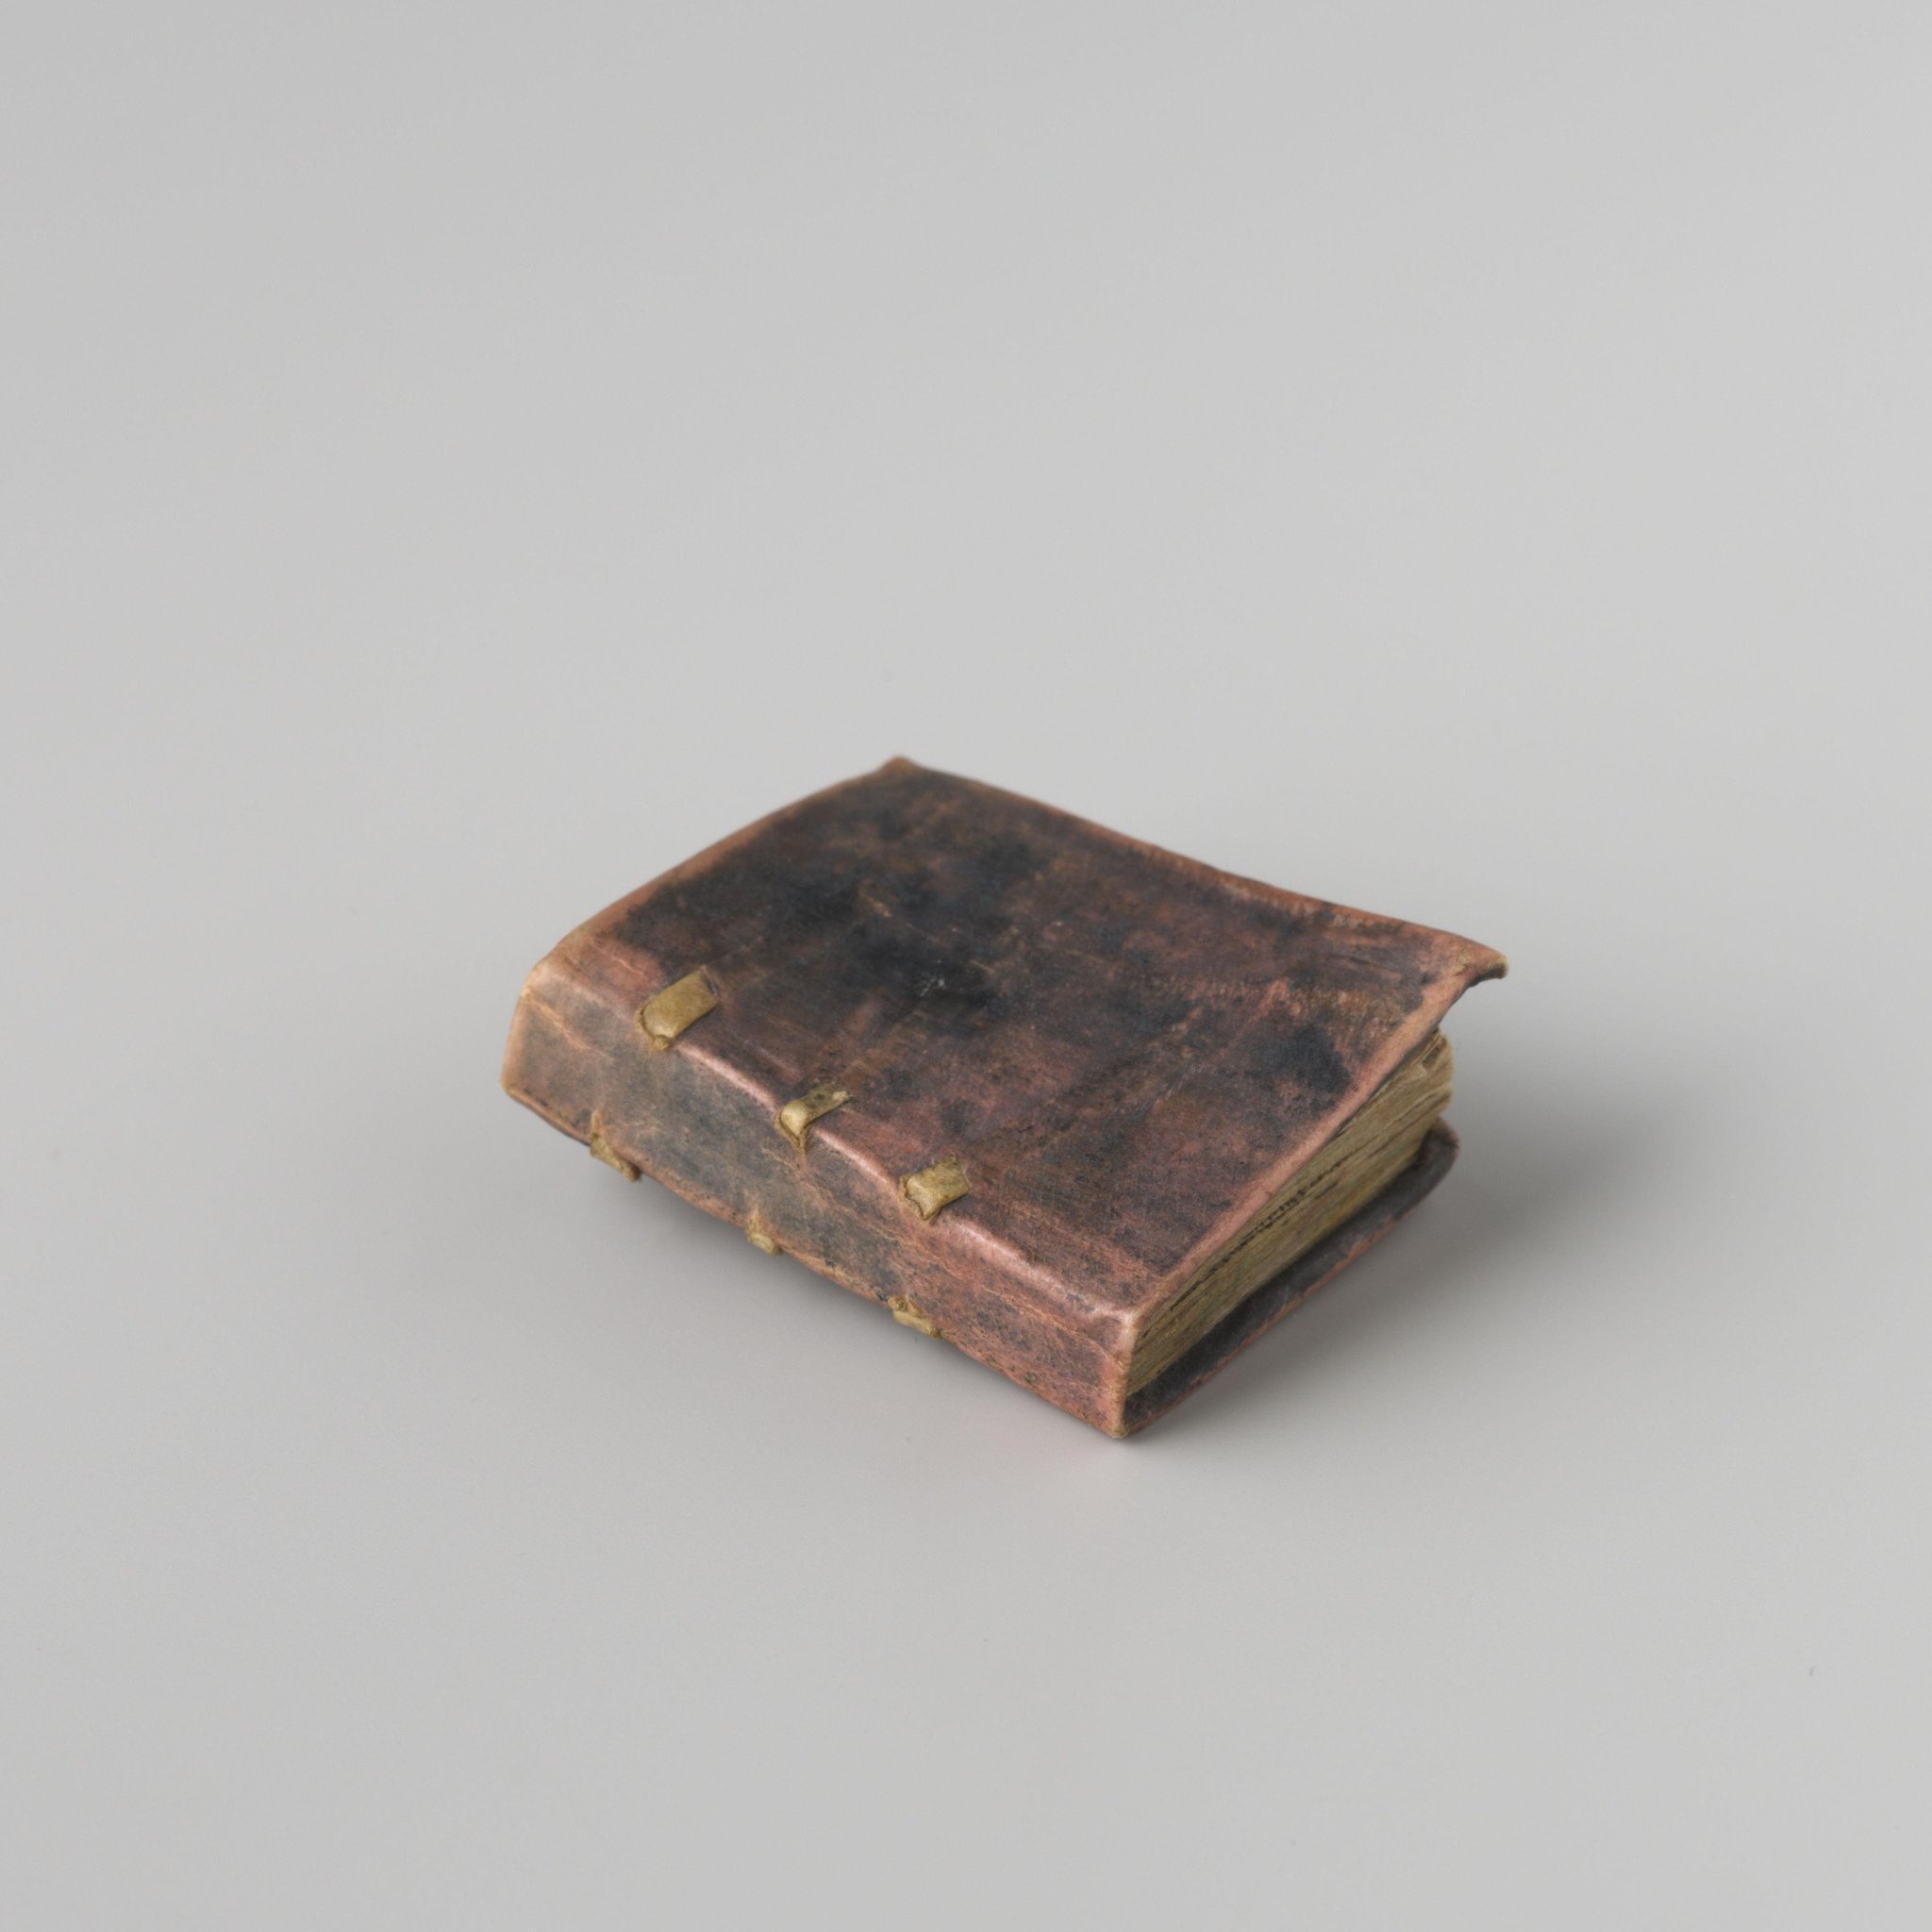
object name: book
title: Boek met stads- en tuingezichten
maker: Anonymous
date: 1690-1710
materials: paper, parchment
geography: amsterdam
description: Boek met stads- en tuingezichten. Ingebonden in roze-blauw gekleurd perkament.